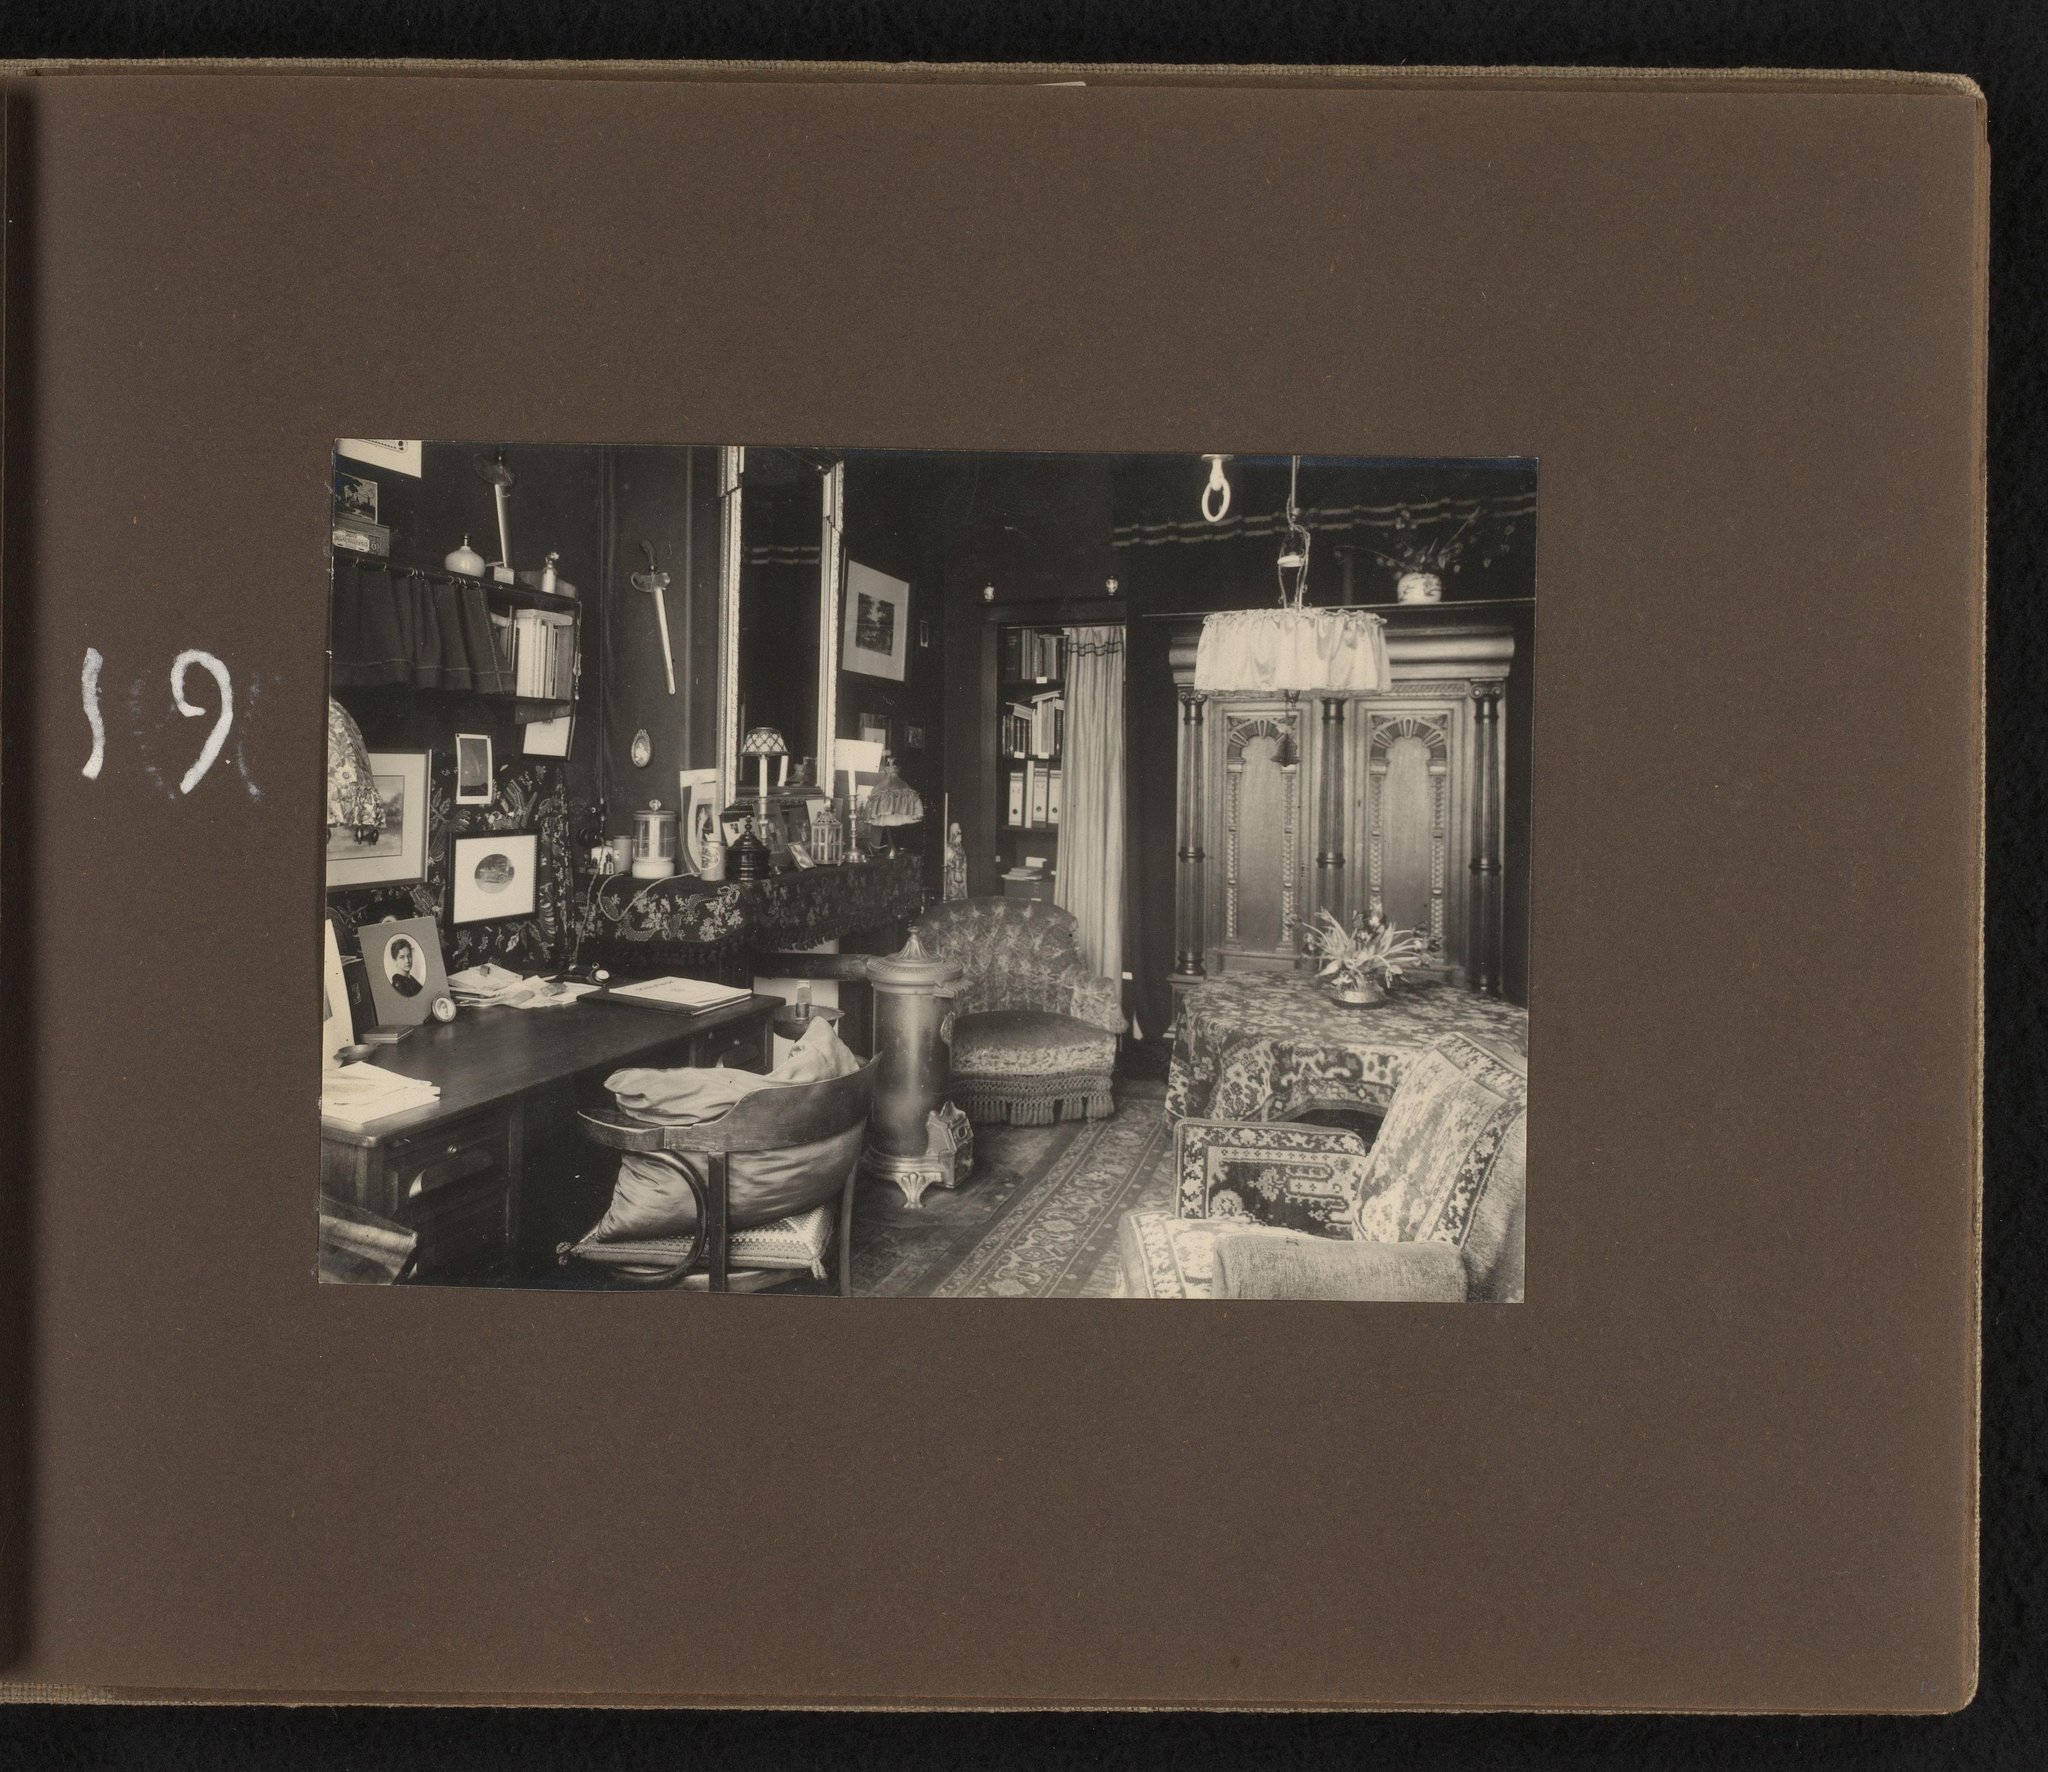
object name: photograph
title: Interieur van het Plantsoen 9B te Leiden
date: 1919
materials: paper, cardboard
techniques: gelatin silver print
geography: leiden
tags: interior of the house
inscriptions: date: ‘1919’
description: Woning van Frederik (Frits) Stokhuyzen. Op het bureau foto's van Johanna (Hans) de Jong. Deze foto maakt deel uit van een album.